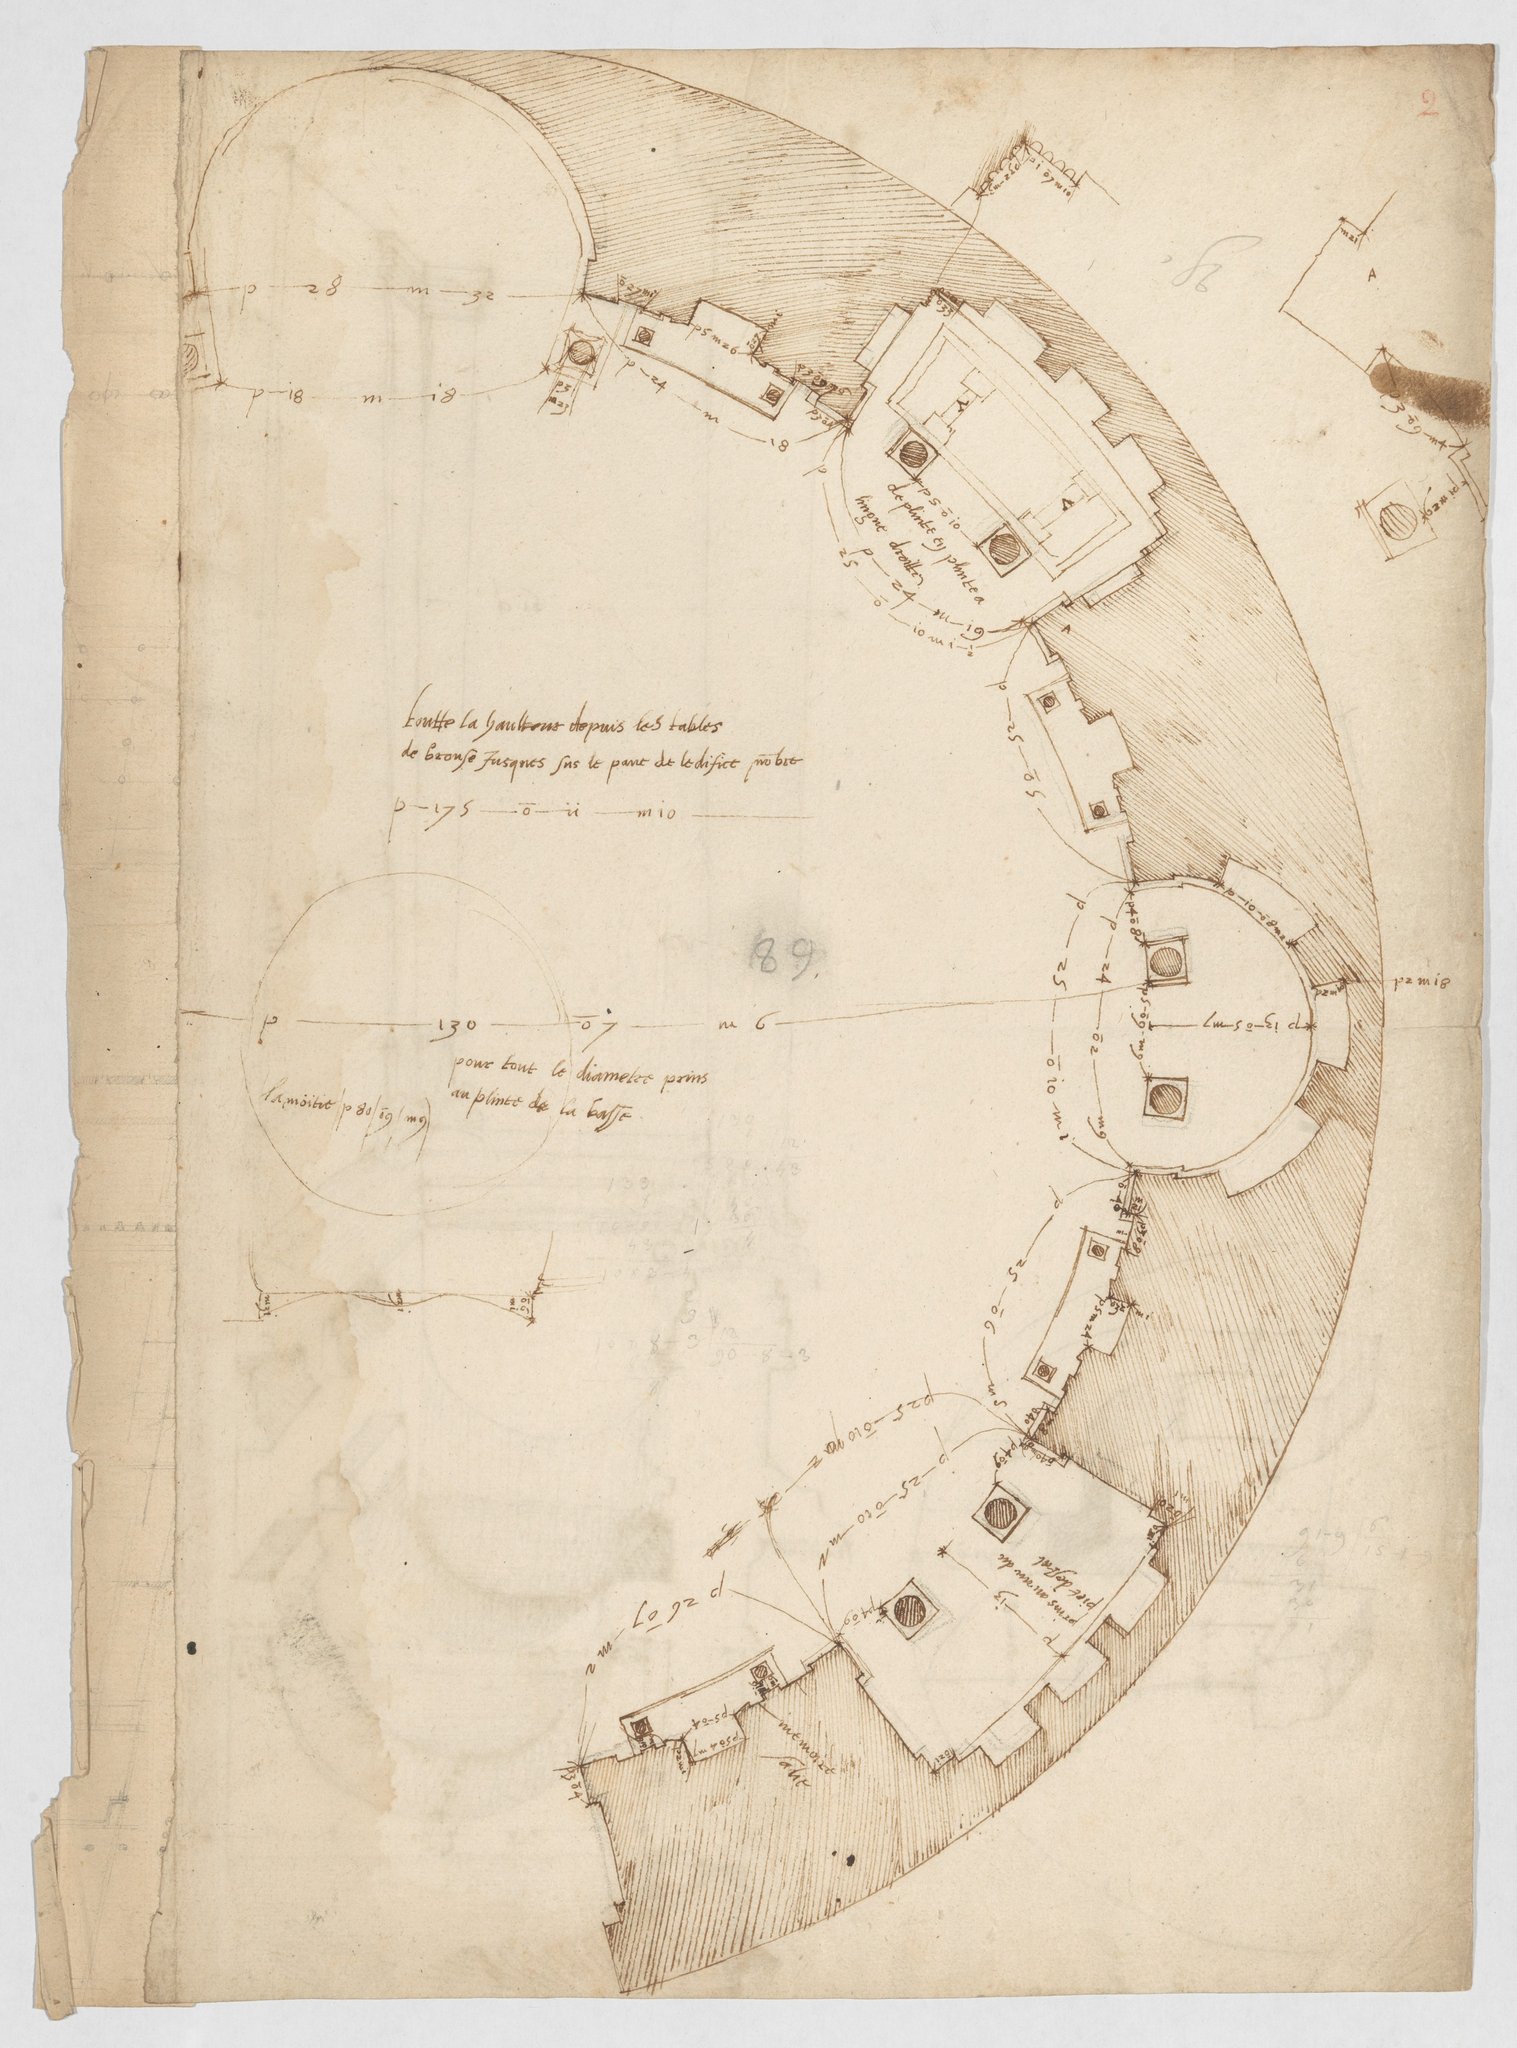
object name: collection ornament architecture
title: Pantheon, partial plan; details (recto) Pantheon, rectangular niche, perspective; vault, detail (verso)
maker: anonymous, french, 16th century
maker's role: draftsman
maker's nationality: french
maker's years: 1500-1600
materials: chalk, ink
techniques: incising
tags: architecture